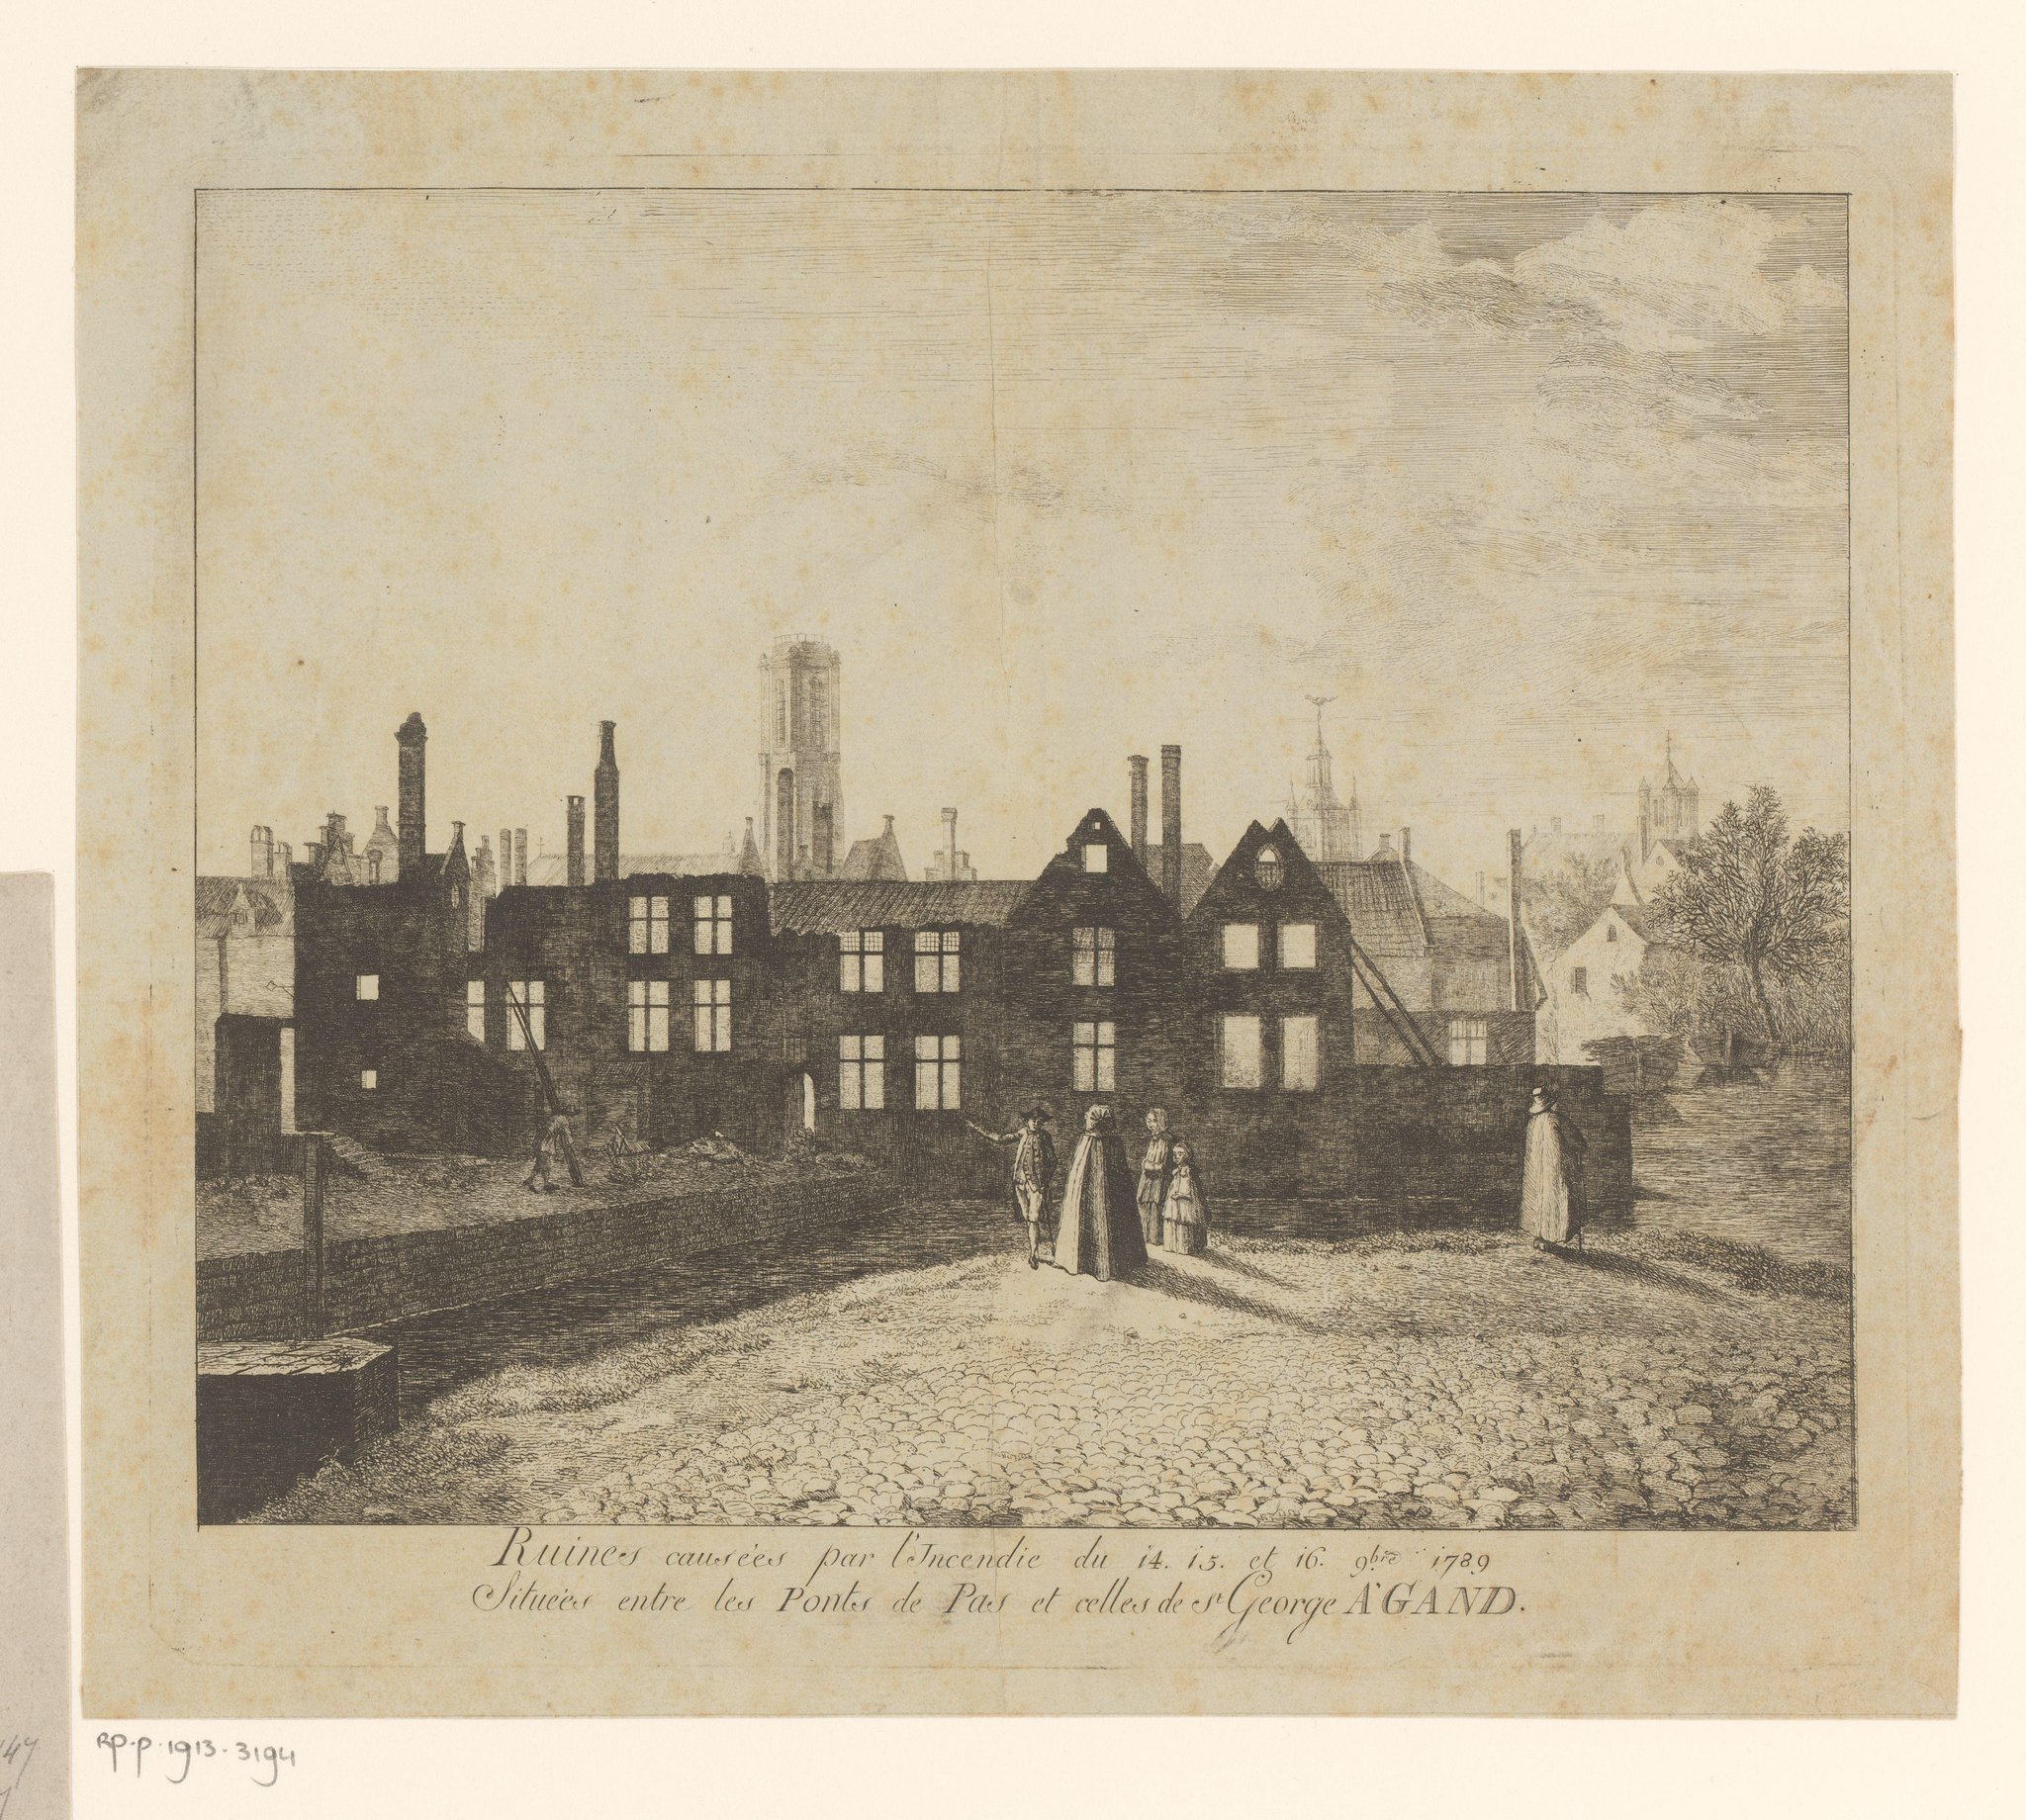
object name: print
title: Ruïnes na een brand tussen de Pasbrug en Sint-Jorisbrug in Gent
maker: jacques andré joseph trachez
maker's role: print maker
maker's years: 1746-1820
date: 1789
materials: paper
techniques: etching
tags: ruin of a building ~ architecture, church (exterior), collapsing building, ruin of a dwelling, house, castle, etc., ghent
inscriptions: collector's mark: Lugt 2228, collector's mark: Lugt 1485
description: Deze brand was een gevolg van beschietingen tijdens de Vier Dagen van Gent.